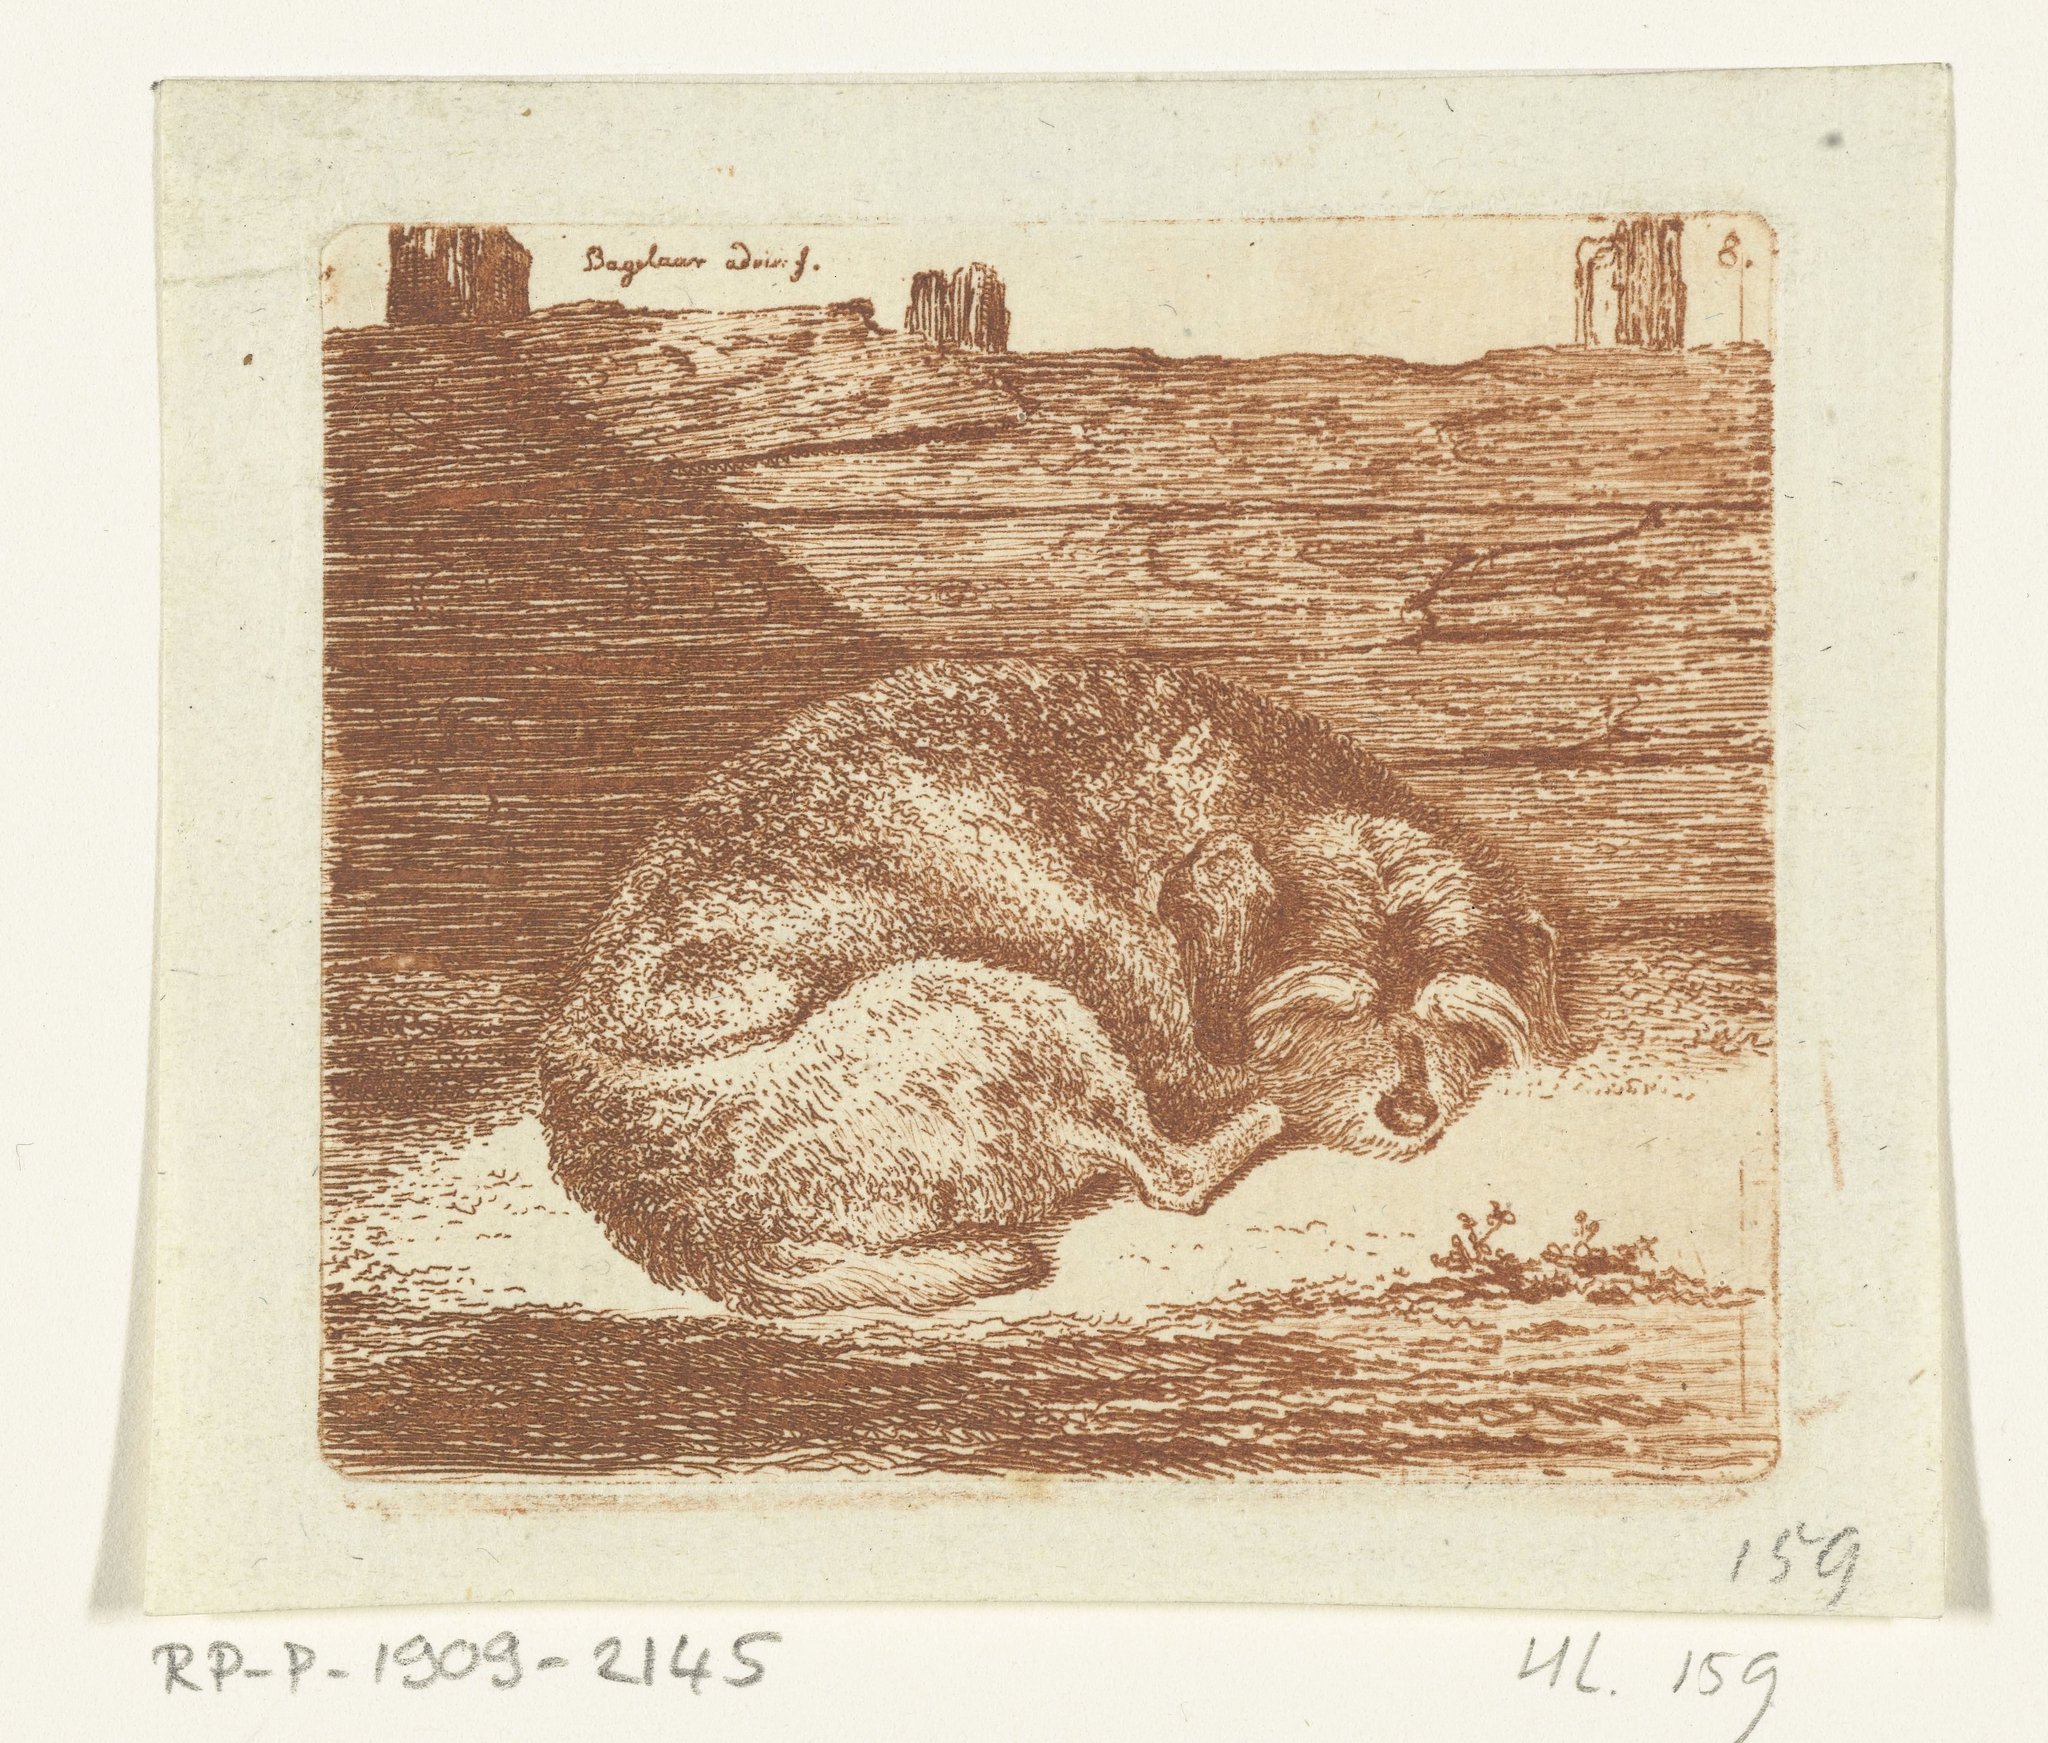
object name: print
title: Slapende hond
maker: ernst willem jan bagelaar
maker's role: draughtsman, print maker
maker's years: 1775-1837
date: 1798-1837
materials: paper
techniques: etching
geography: netherlands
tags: dog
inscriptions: collector's mark: Lugt 2228